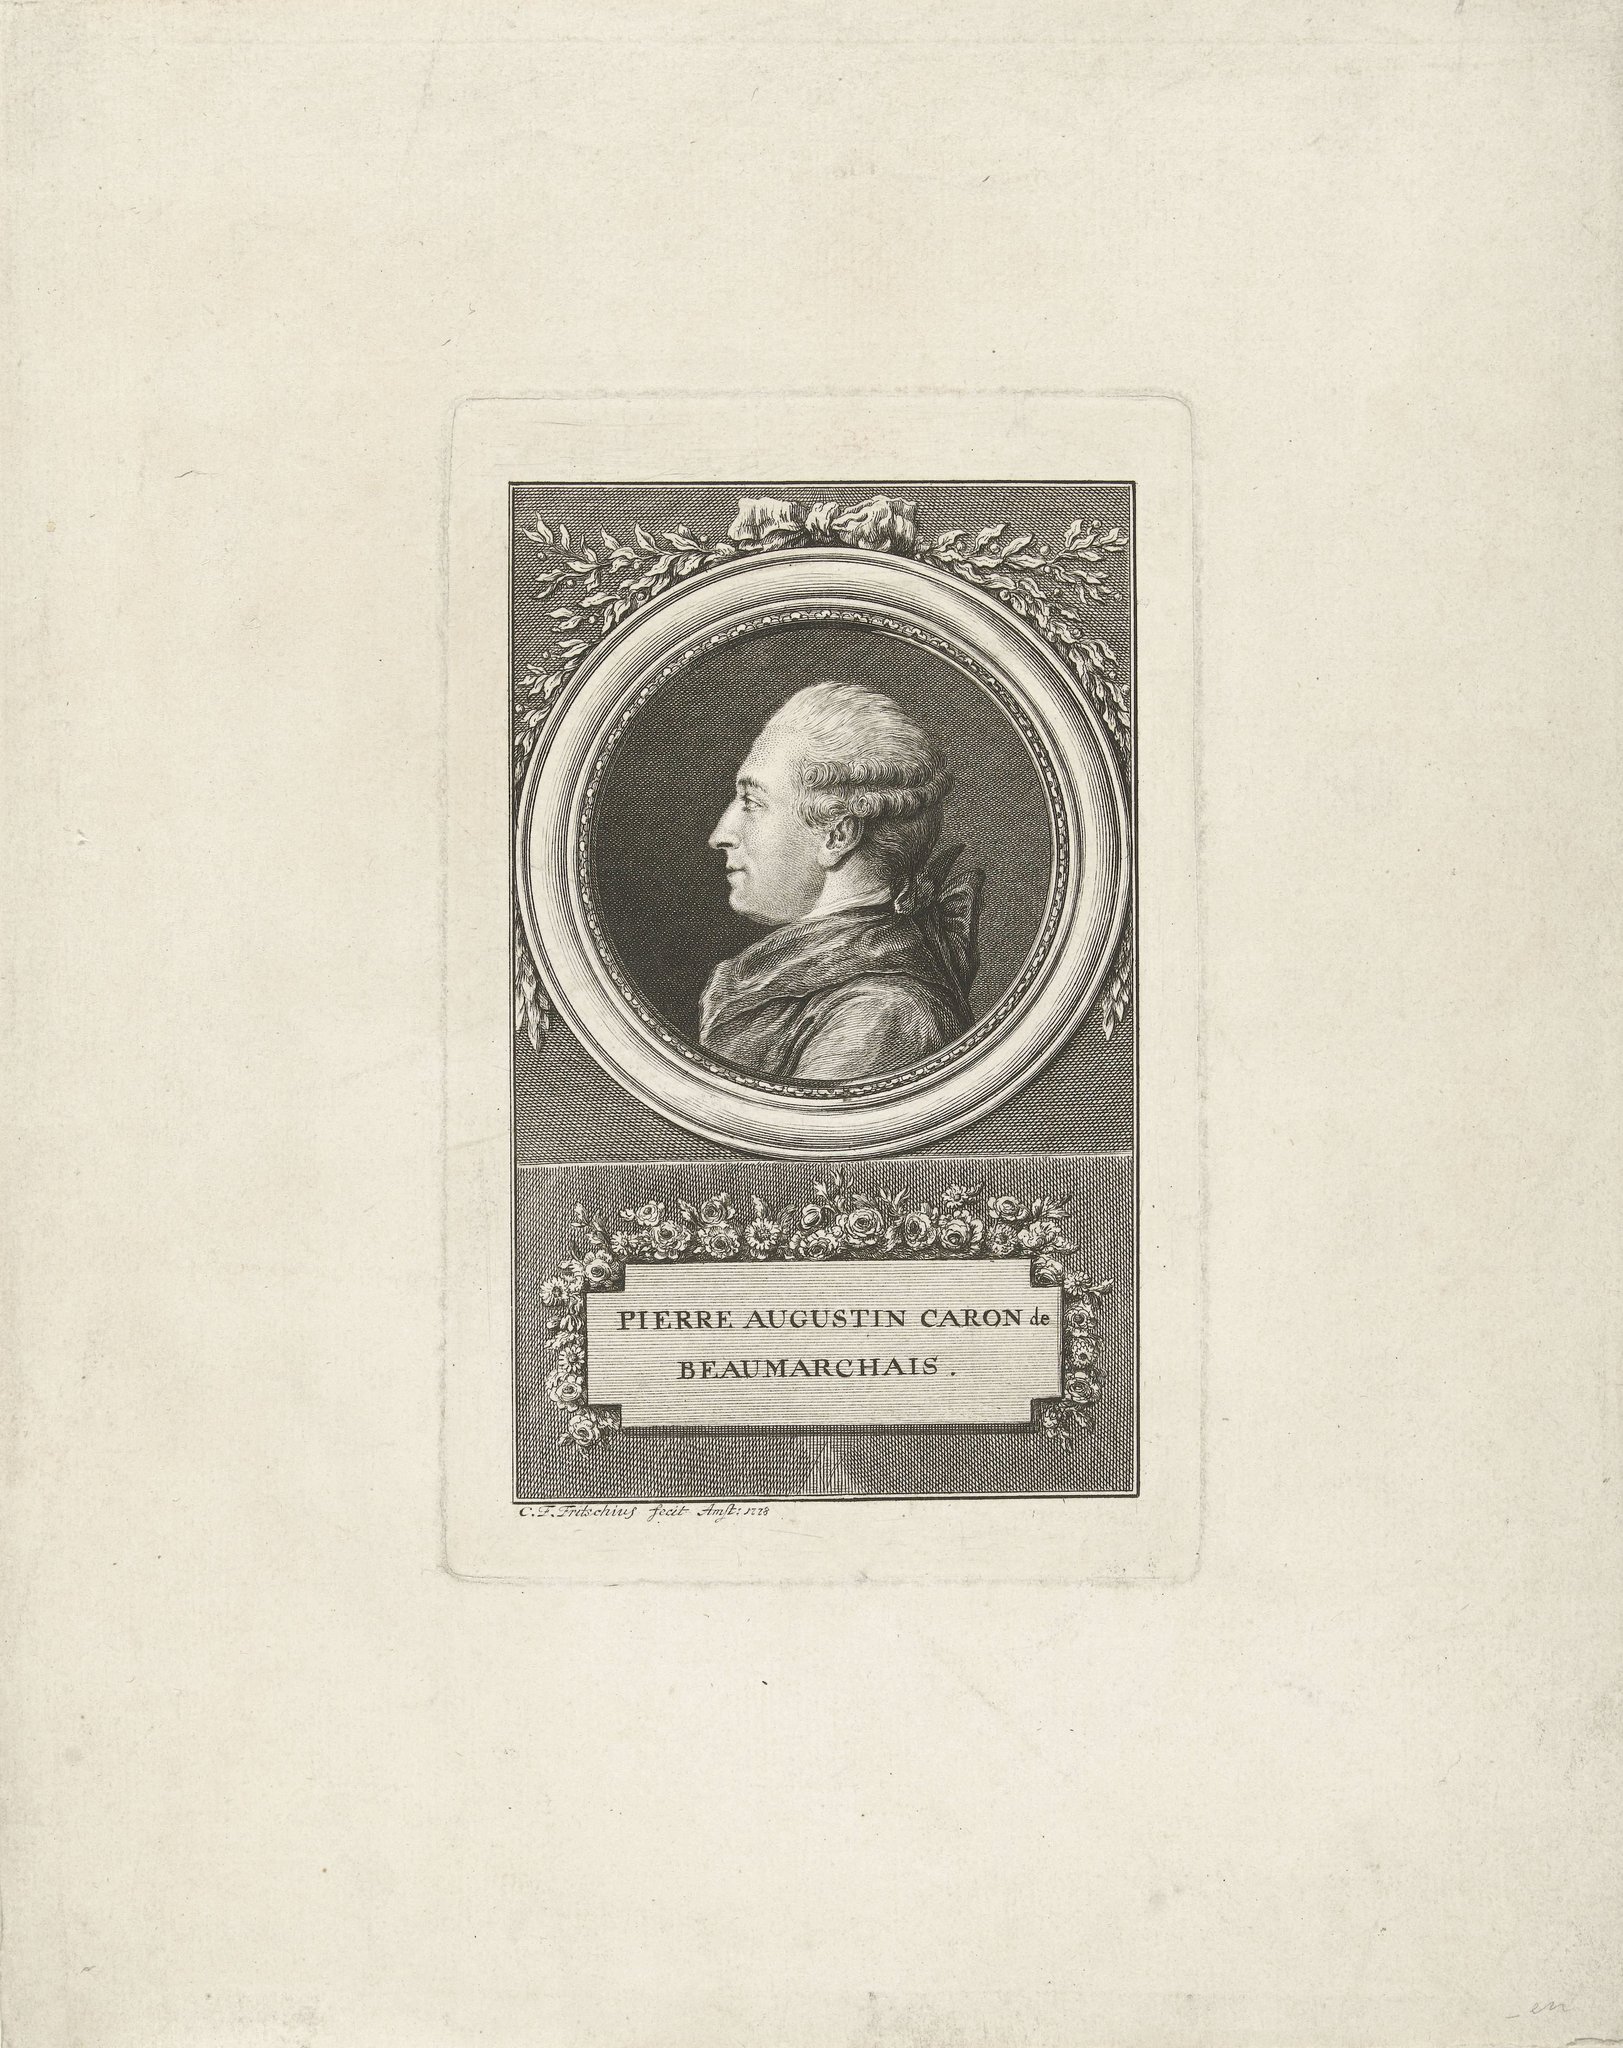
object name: print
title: Portret van Pierre Beaumarchais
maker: christian friedrich fritzsch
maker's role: print maker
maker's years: 1719-1774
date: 1778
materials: paper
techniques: engraving, etching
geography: amsterdam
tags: paris, publisher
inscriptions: collector's mark: Lugt 2228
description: Medaillonportret van de Franse schrijver en uitgever Pierre Beaumarchais. Het medaillon is versierd met olijftakken en een lint. Onder het portret staat op een met bloemen omgeven cartouche de naam van de geportretteerde.